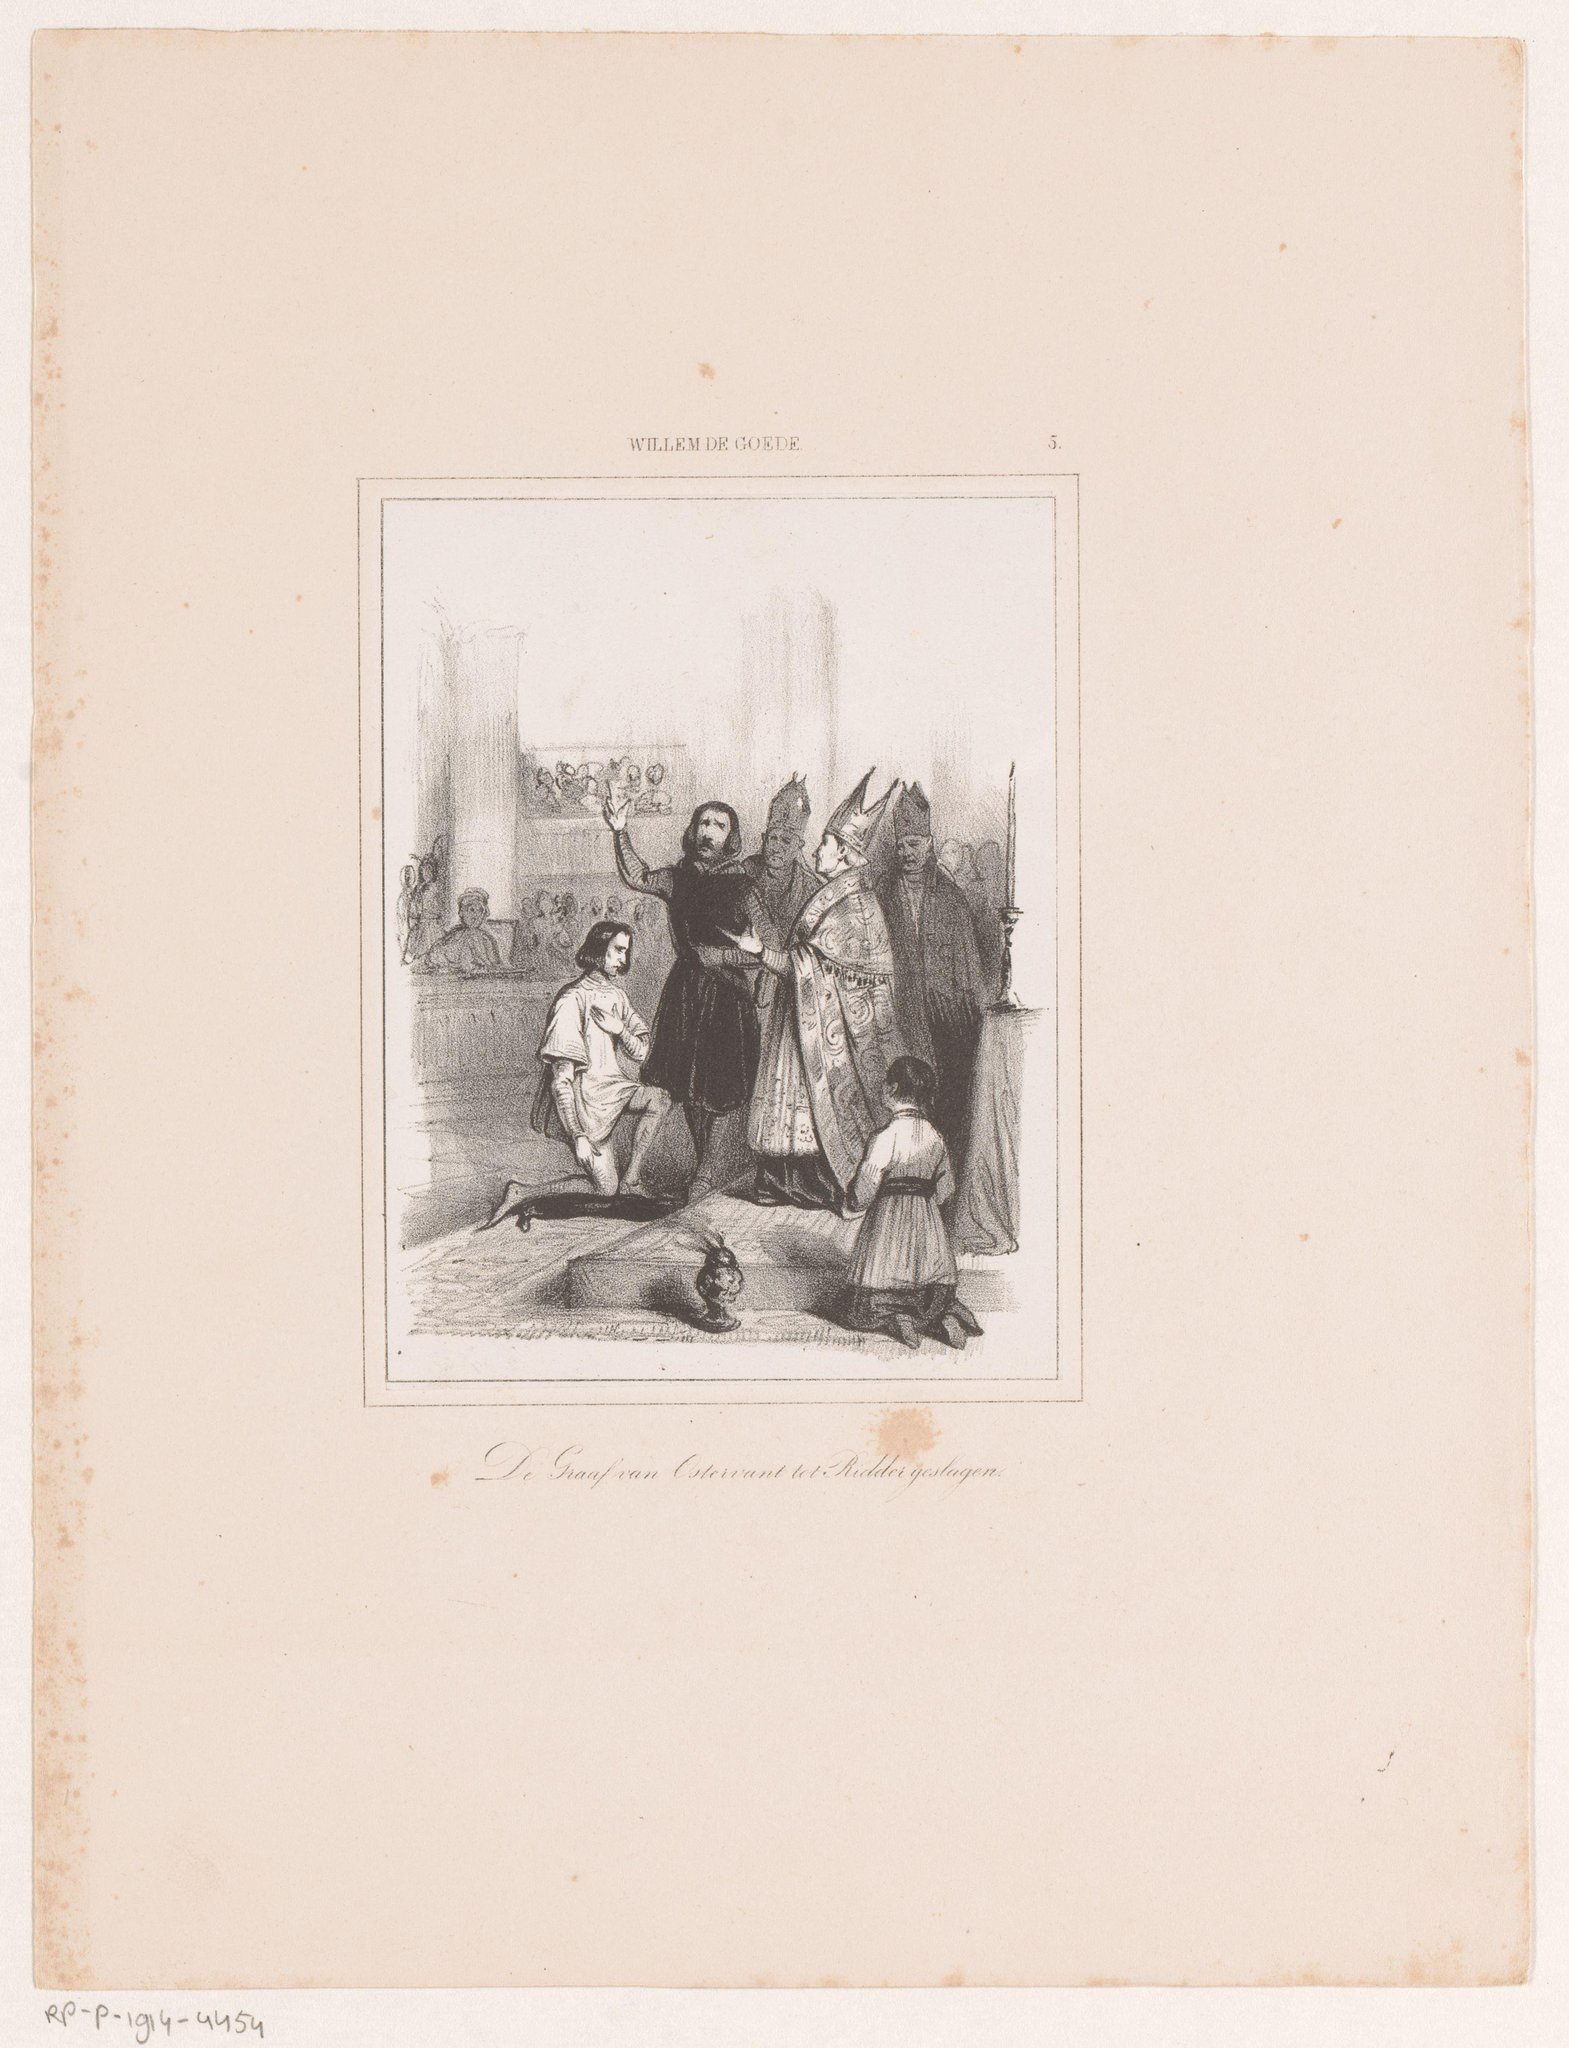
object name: print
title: Zoon van Willem de Goede wordt tot ridder geslagen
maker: herman frederik carel ten kate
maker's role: draughtsman, painter, print maker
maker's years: 1822-1891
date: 1842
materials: paper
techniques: lithograph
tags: willem iii de goede (graaf van holland en henegouwen), becoming a knight, knighting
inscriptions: collector's mark: Lugt 2228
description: Omdat zijn zoon zijn leven heeft gered op het slagveld laat Willem de Goede hem tot ridder slaan. Genummerd rechtsboven: 5.